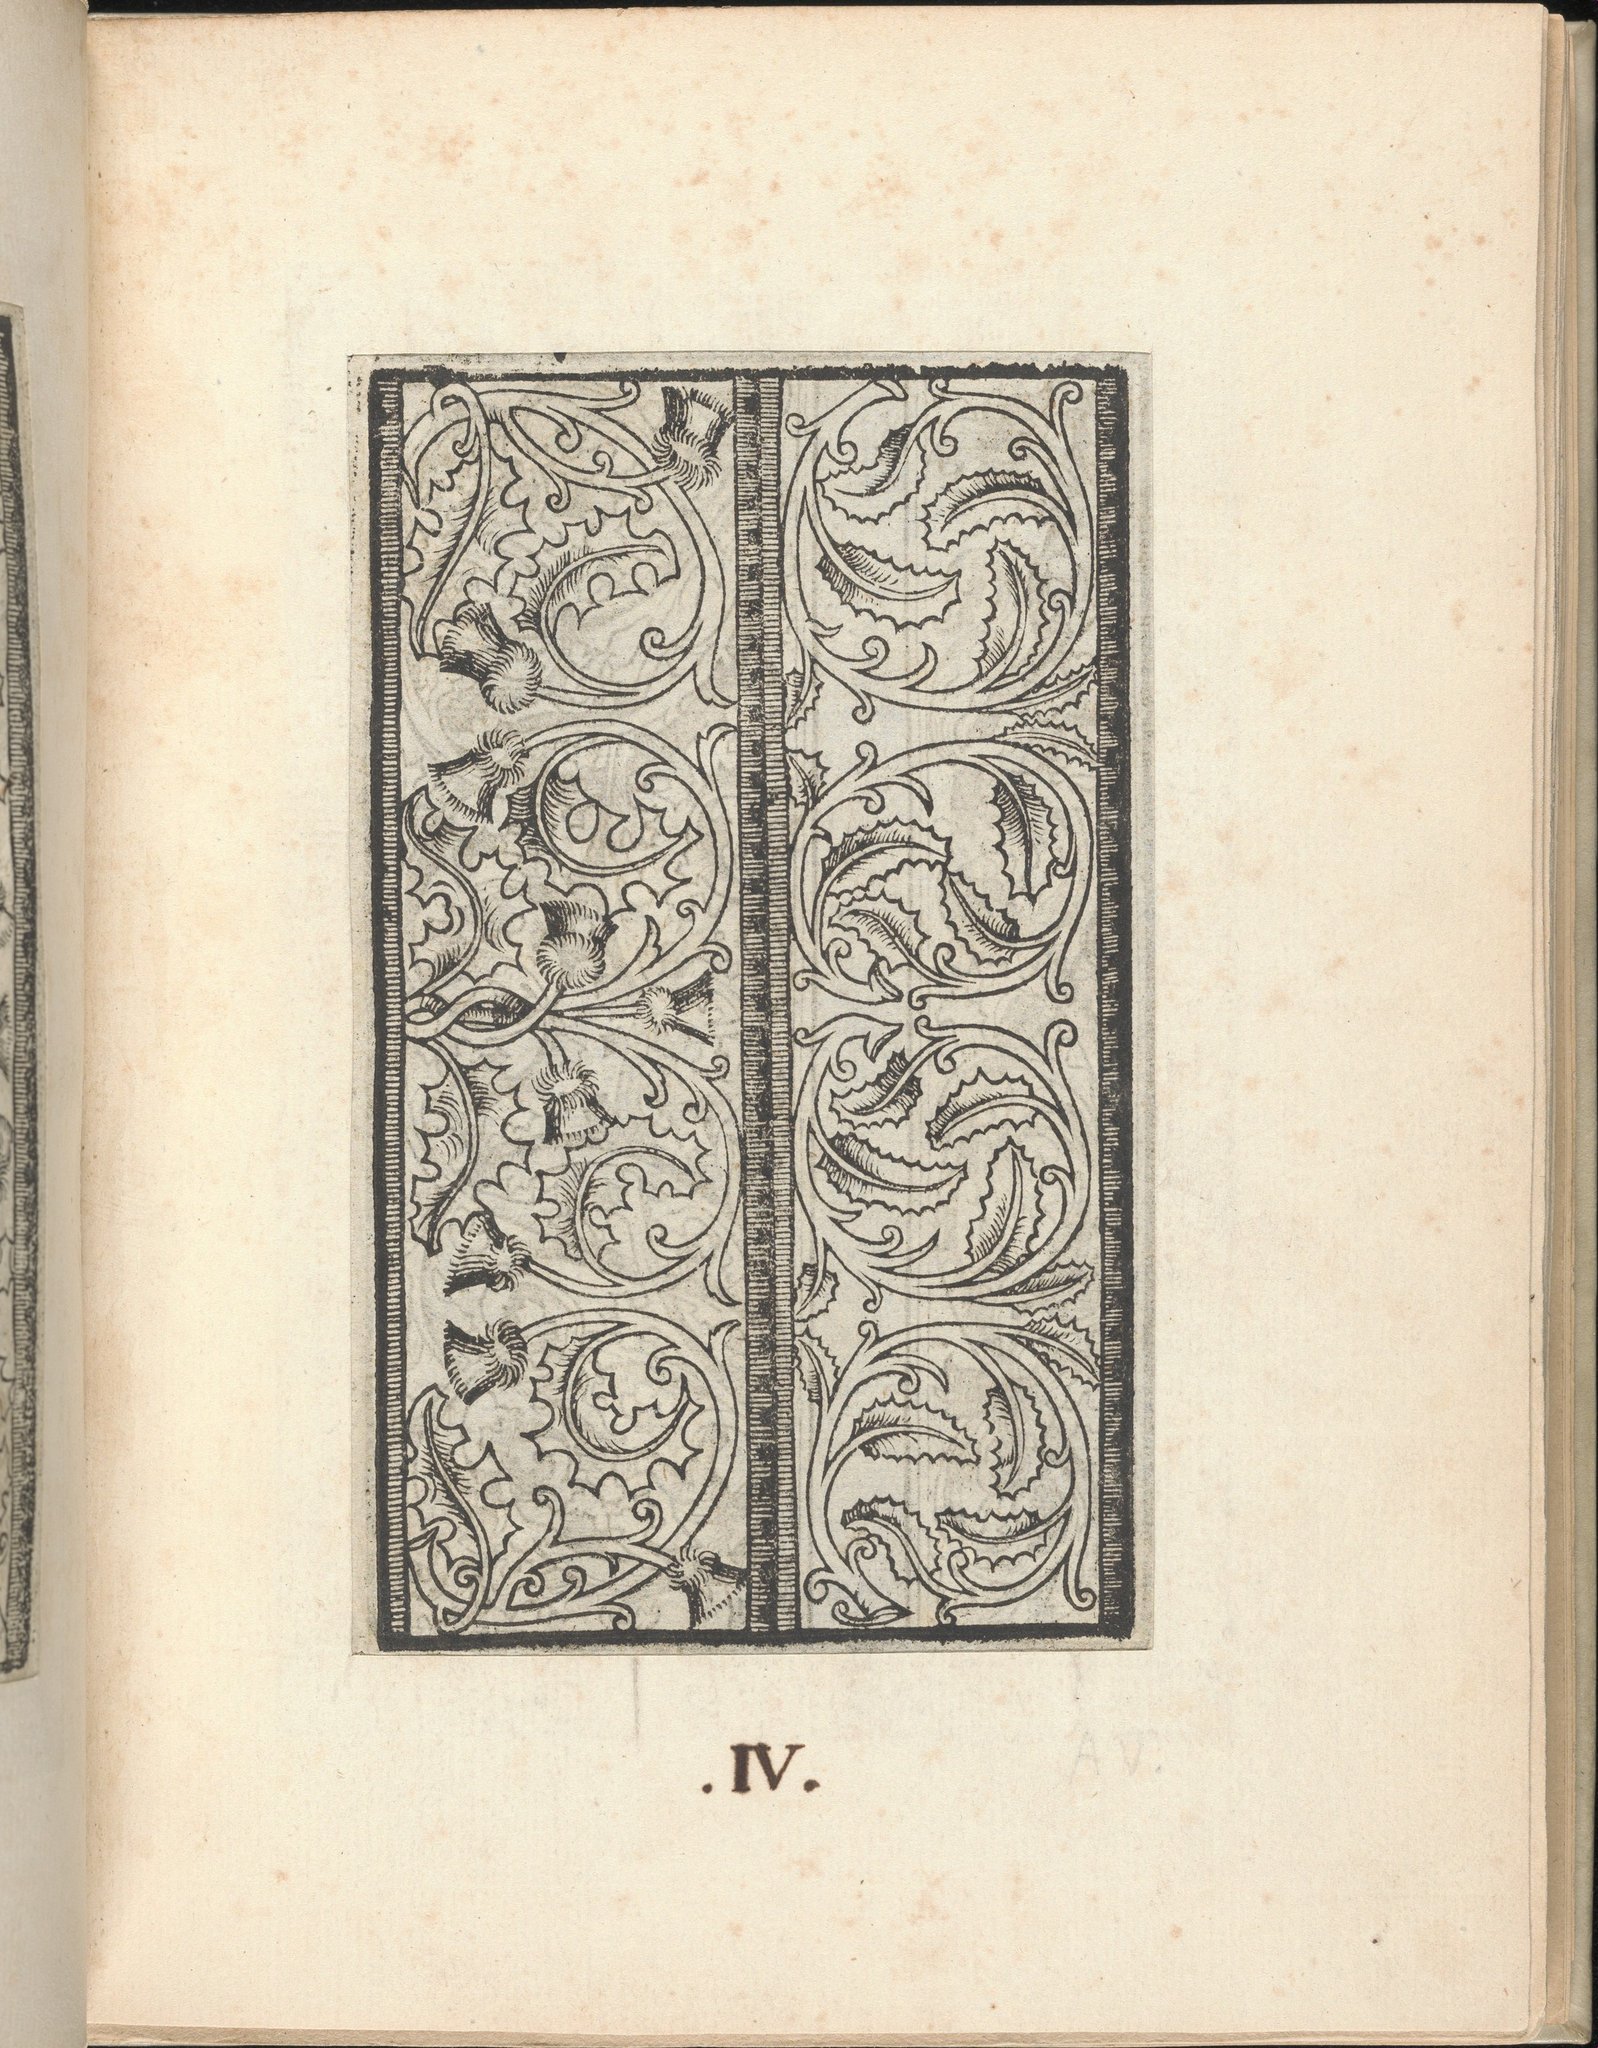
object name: book print ornament architecture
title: Esemplario di lavori, page 4 (recto)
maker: nicolò zoppino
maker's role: publisher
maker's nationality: italian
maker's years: 1478-1544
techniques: bookbinding, inlay, woodcut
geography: italy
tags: leaves,vines